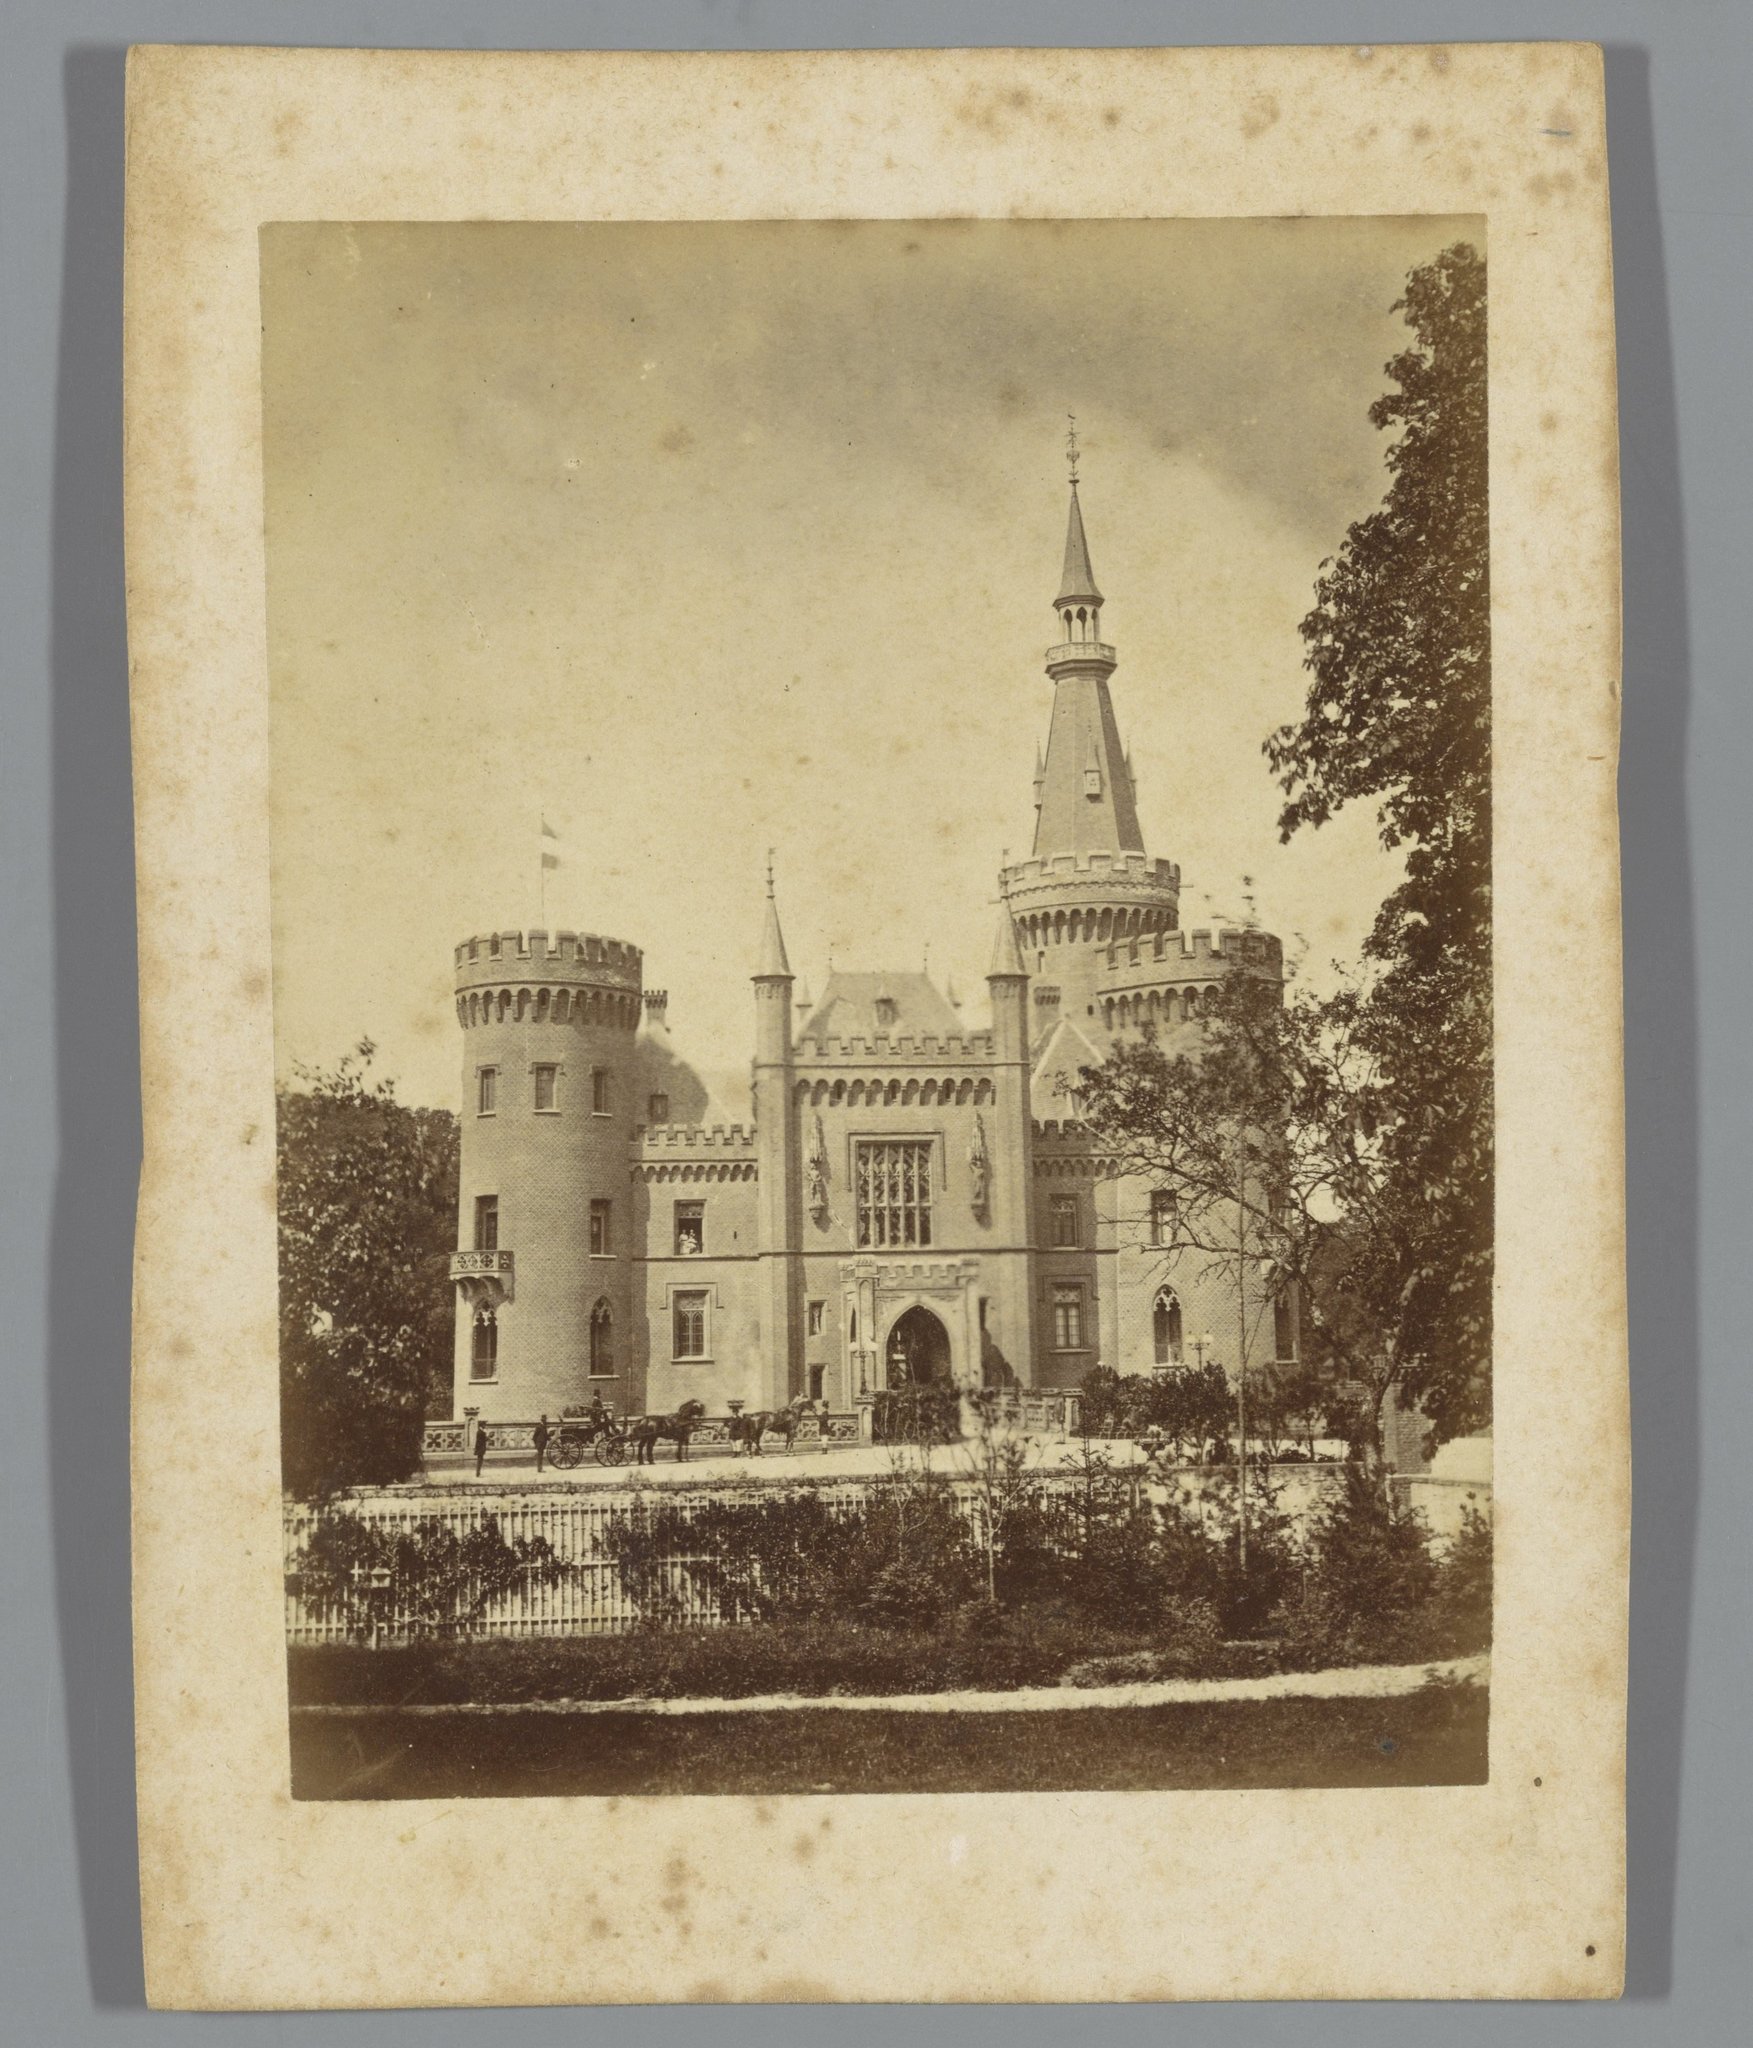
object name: photograph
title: Schloss Moyland nabij Kleef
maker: Anonymous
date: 1880-1900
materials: cardboard, paper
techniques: albumen print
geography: bedburg-hau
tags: castle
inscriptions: collector's mark: ‘Vosmaer’